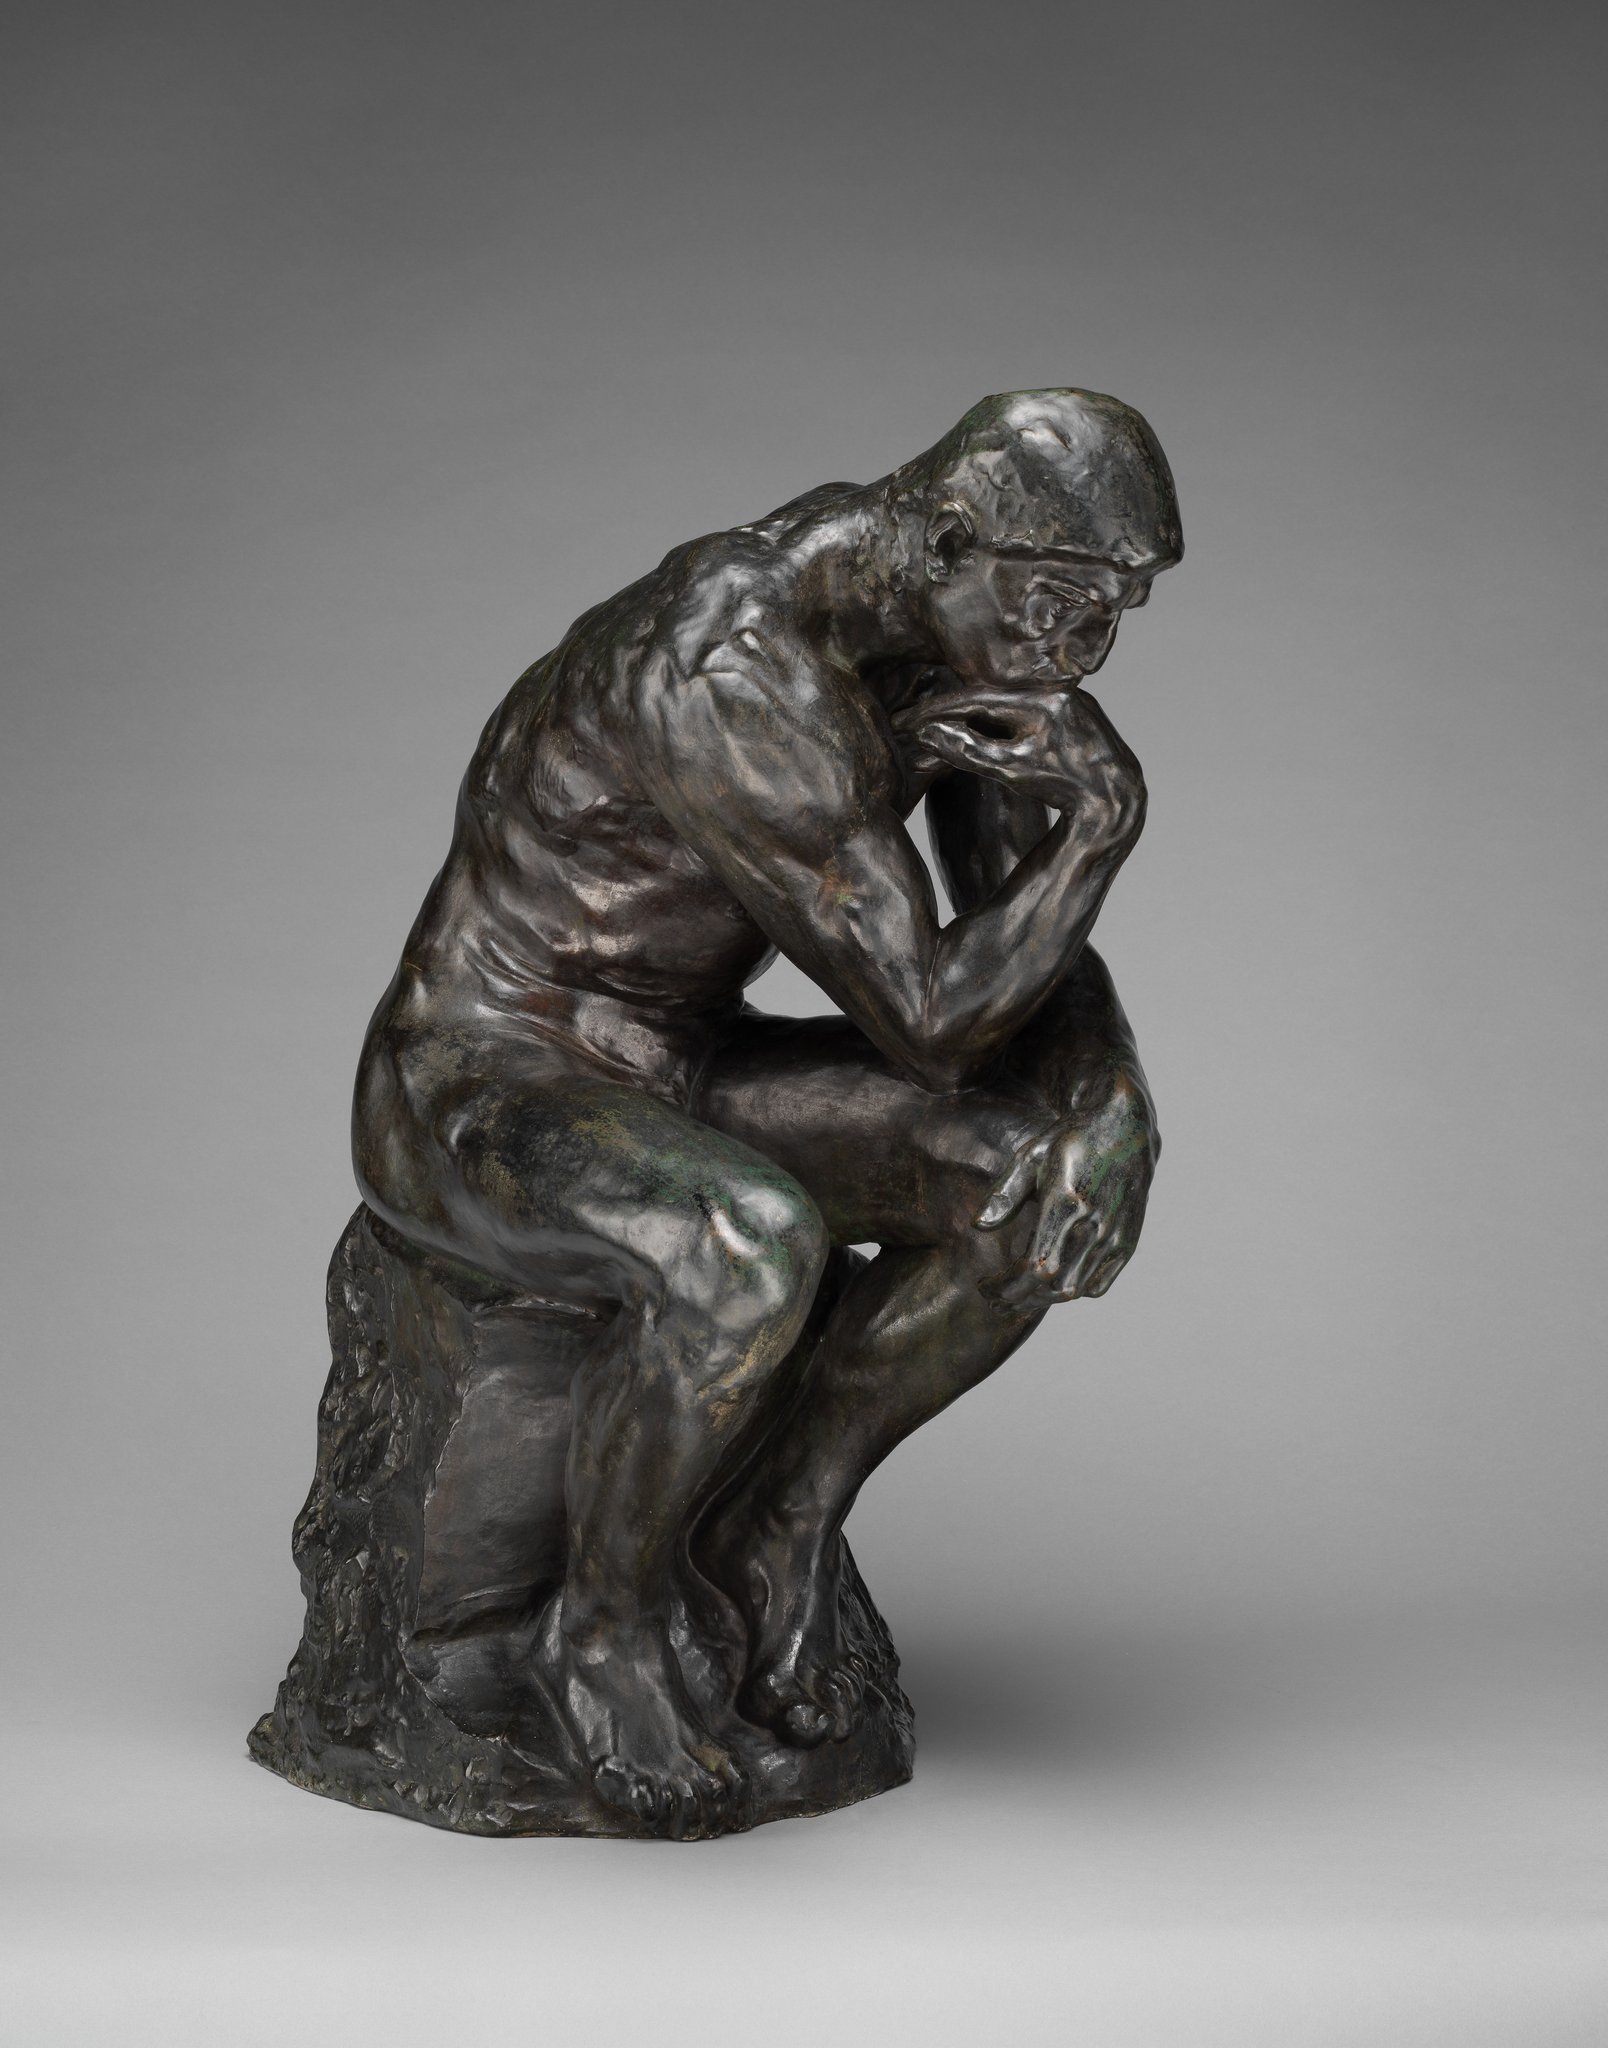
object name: statue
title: The Thinker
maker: auguste rodin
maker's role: artist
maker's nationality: french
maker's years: 1840-1917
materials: bronze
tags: contemplation,men,male nudes